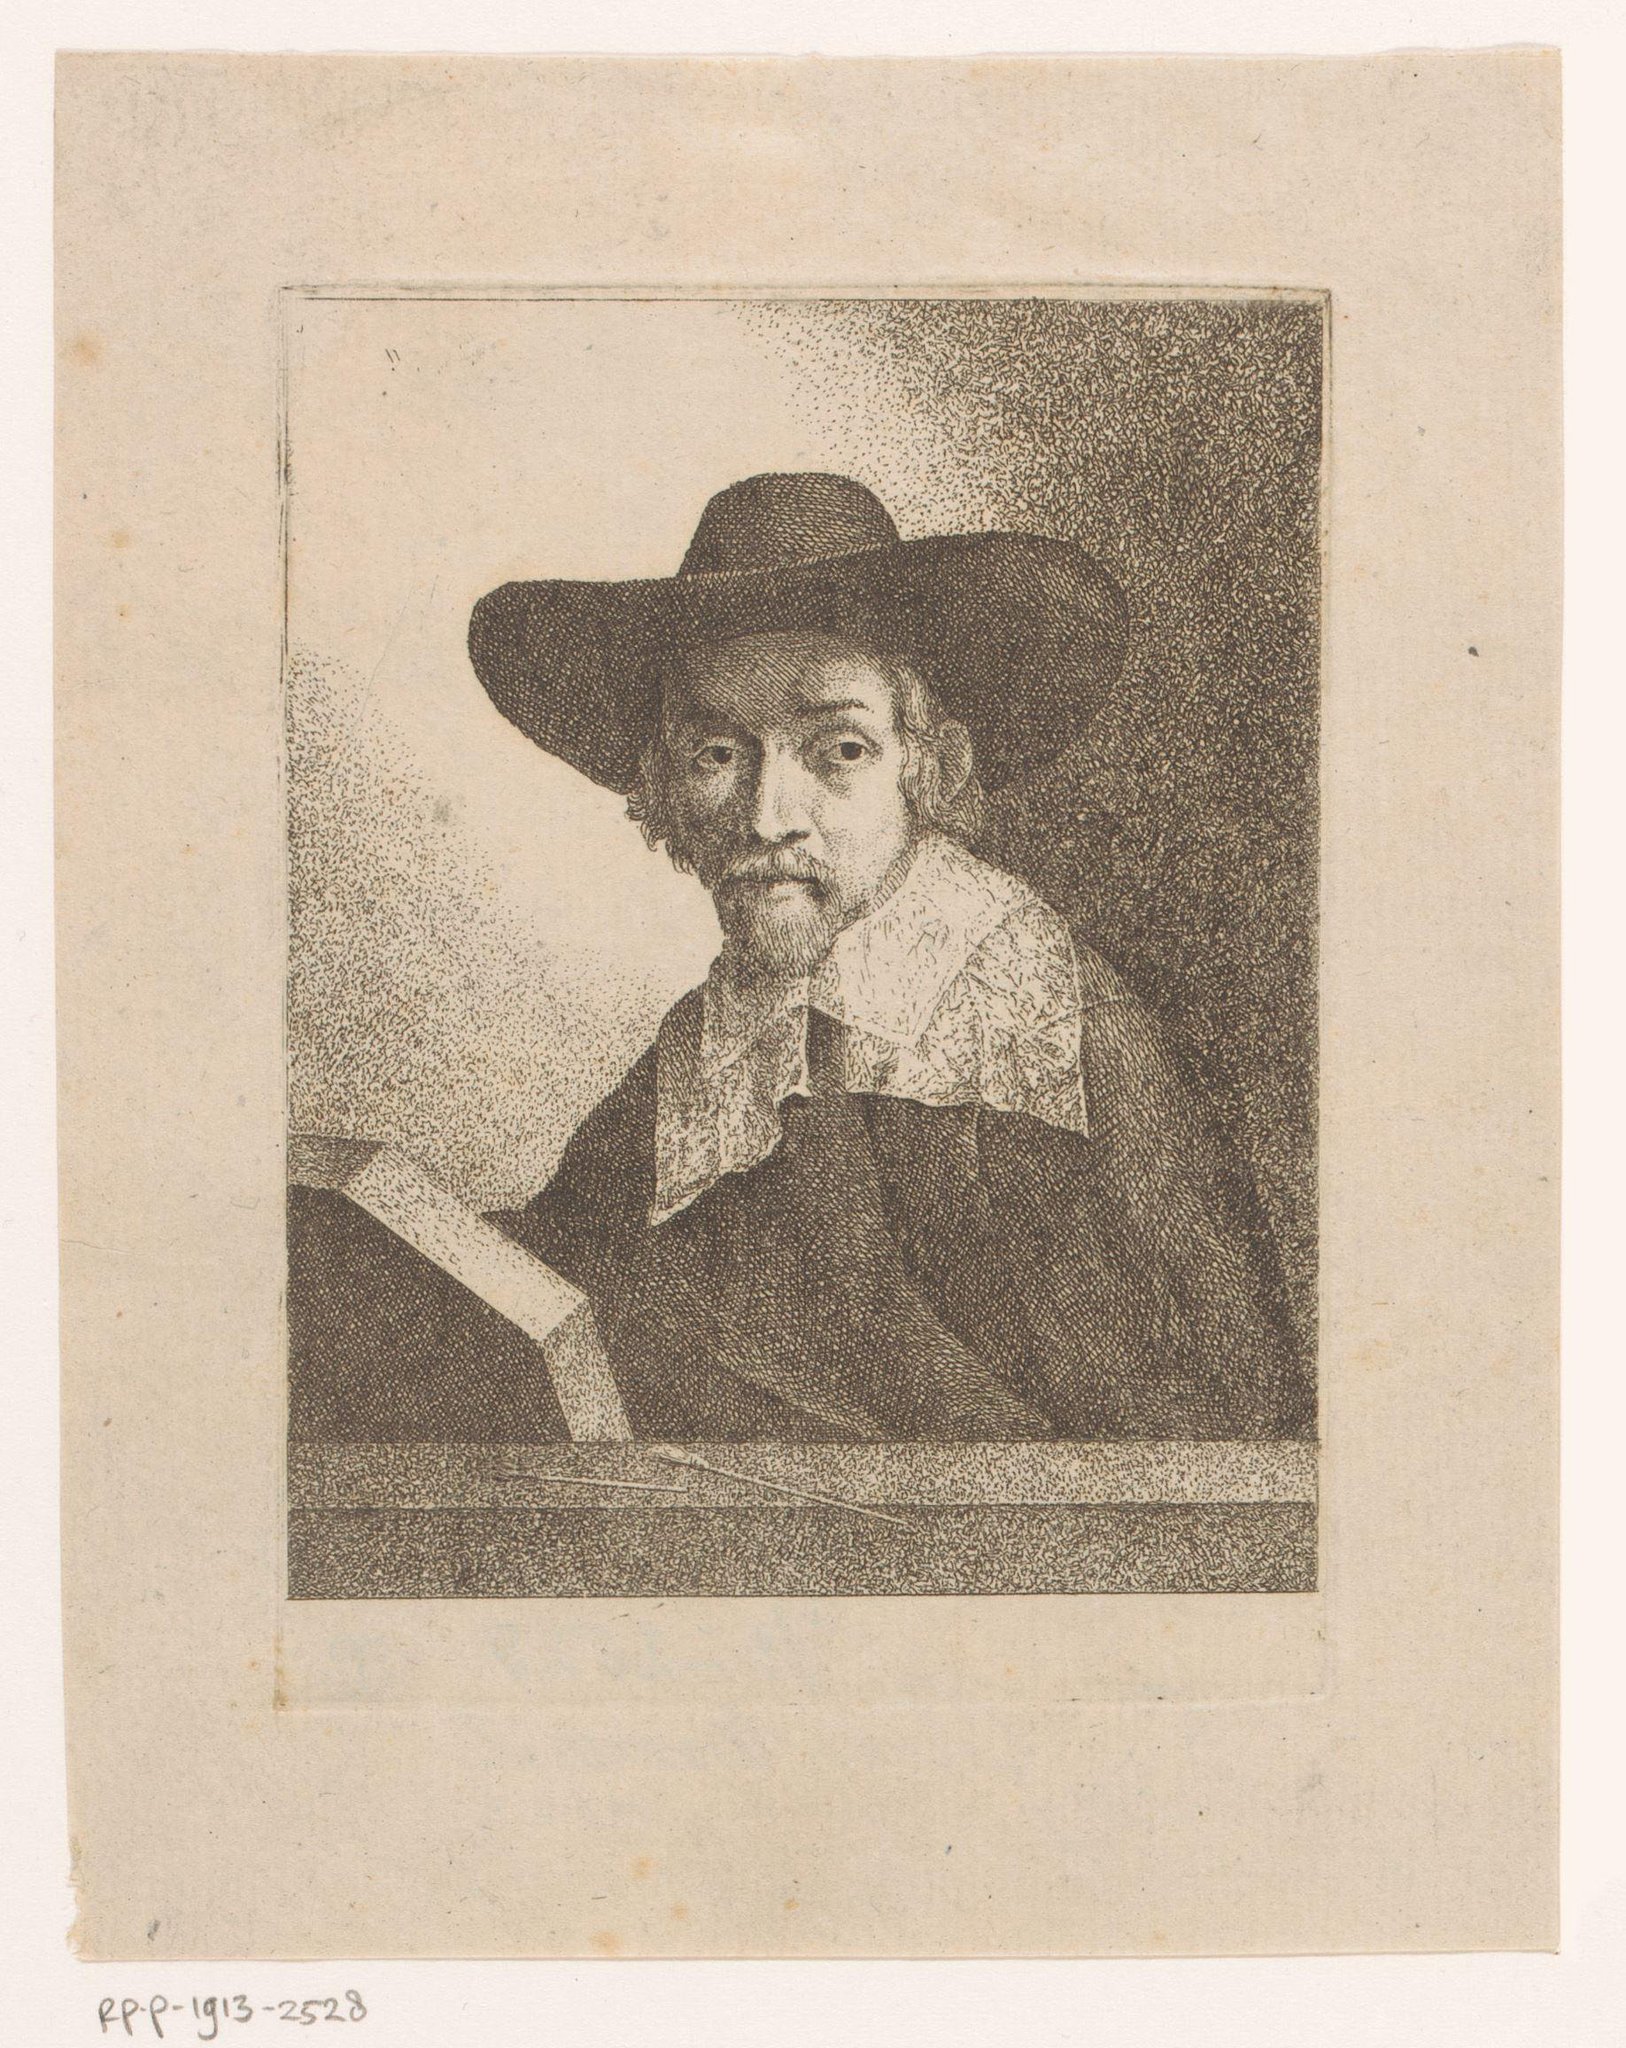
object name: print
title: Portret van Jan Asselijn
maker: andreas bernardus de quertenmont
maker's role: draughtsman, print maker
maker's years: 1750-1835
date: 1760-1835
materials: paper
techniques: etching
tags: draughtsman, jan asselijn, head-gear, adult man, historical persons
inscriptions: collector's mark: Lugt 2228, collector's mark: Lugt 1485